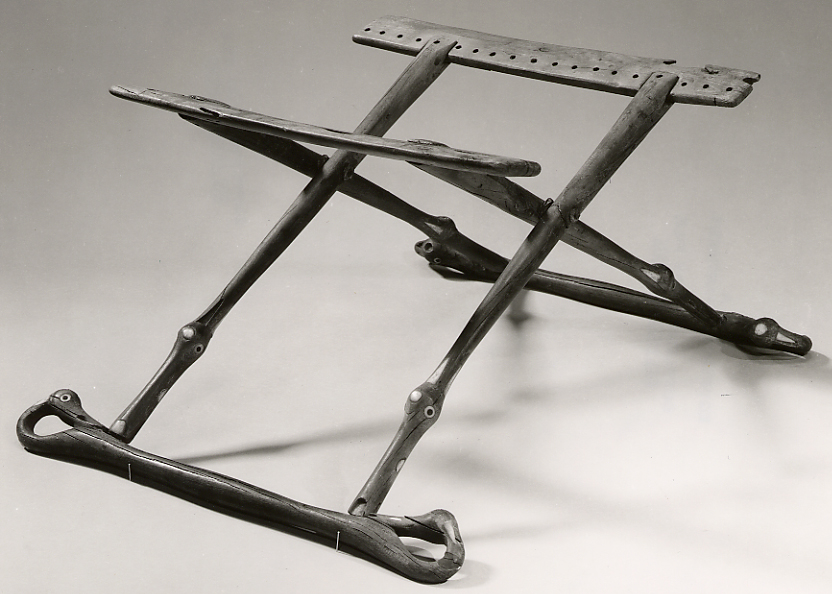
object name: folding stool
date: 1550-1295 BCE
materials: wood, ivory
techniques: inlay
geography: egypt